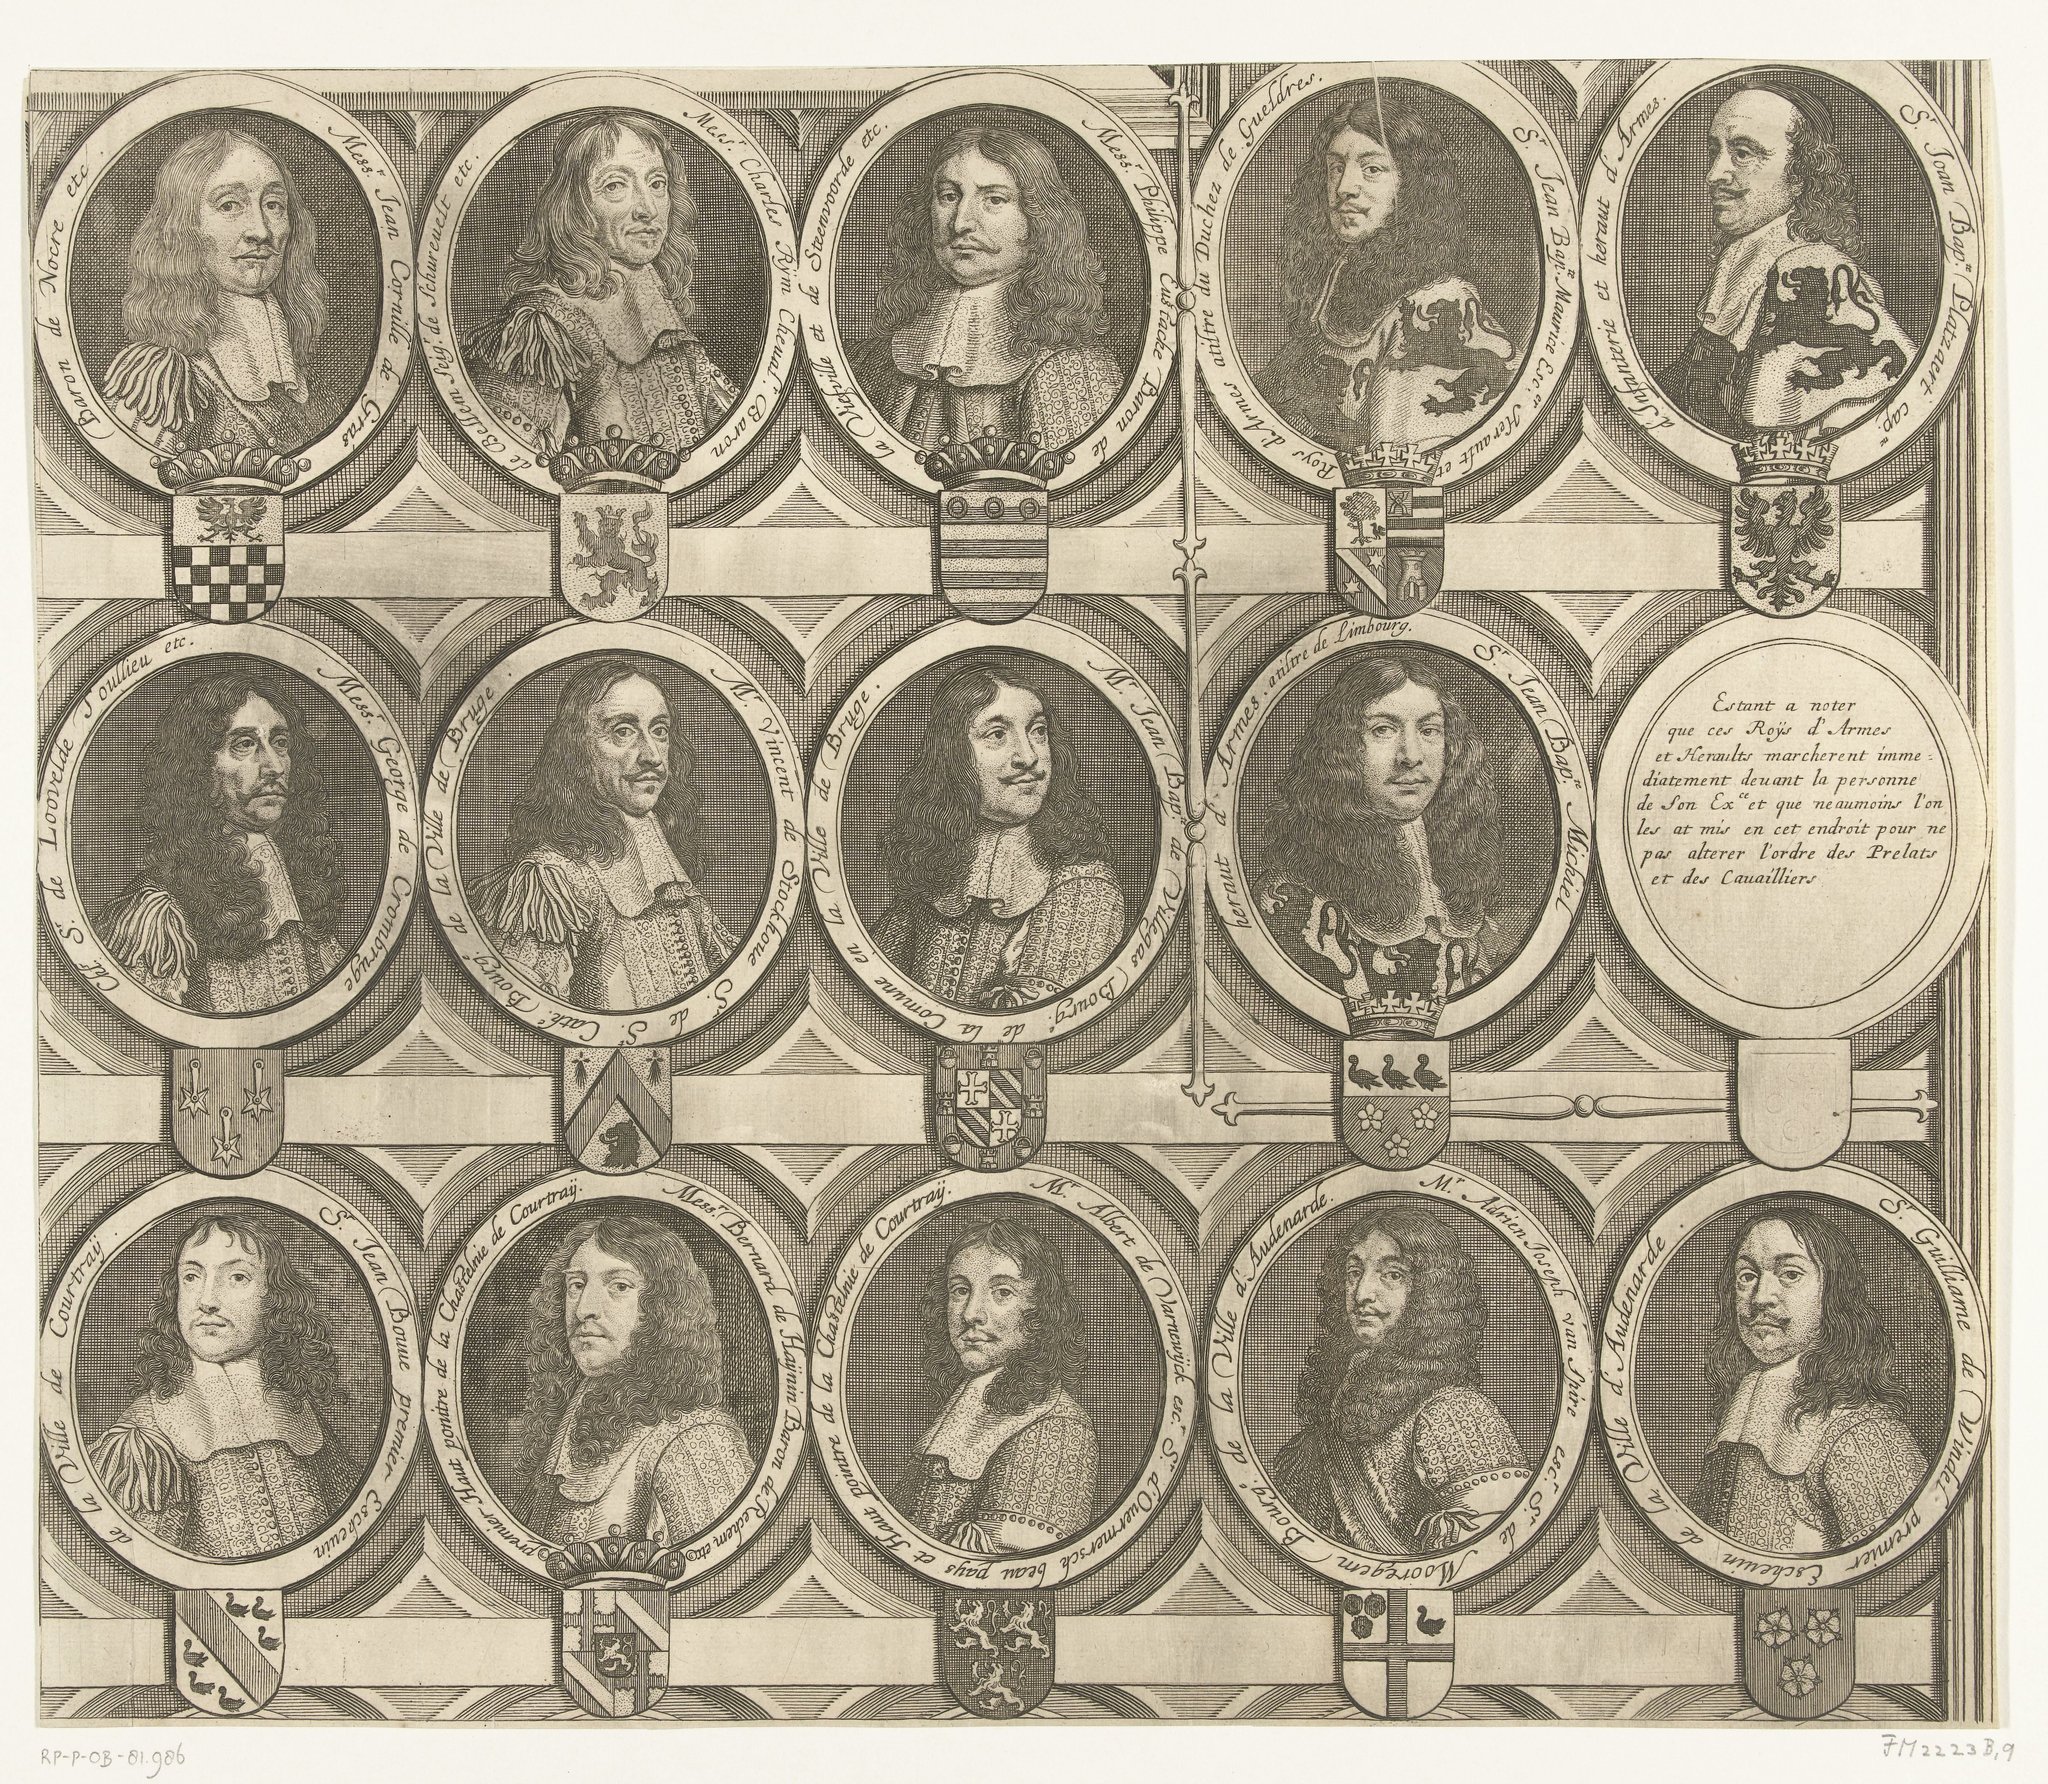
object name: print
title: Proclamatie te Gent van Karel II van Spanje als graaf van Vlaanderen (blad 9), 1666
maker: lucas vorsterman (ii)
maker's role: print maker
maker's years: 1624-1667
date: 1666-1667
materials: paper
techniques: engraving, etching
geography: southern netherlands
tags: karel ii (koning van spanje)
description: Ceremonie op de Vrijdagmarkt te Gent bij de proclamatie van de Spaanse koning Karel II als graaf van Vlaanderen, 2 mei 1666. Blad 9 in een ongemonteerde ensemble van 12 platen van de ceremonie en cavalcade op het plein en 118 portretten van de hoogwaardigheidsbekleders die bij de plechtigheid aanwezig waren.